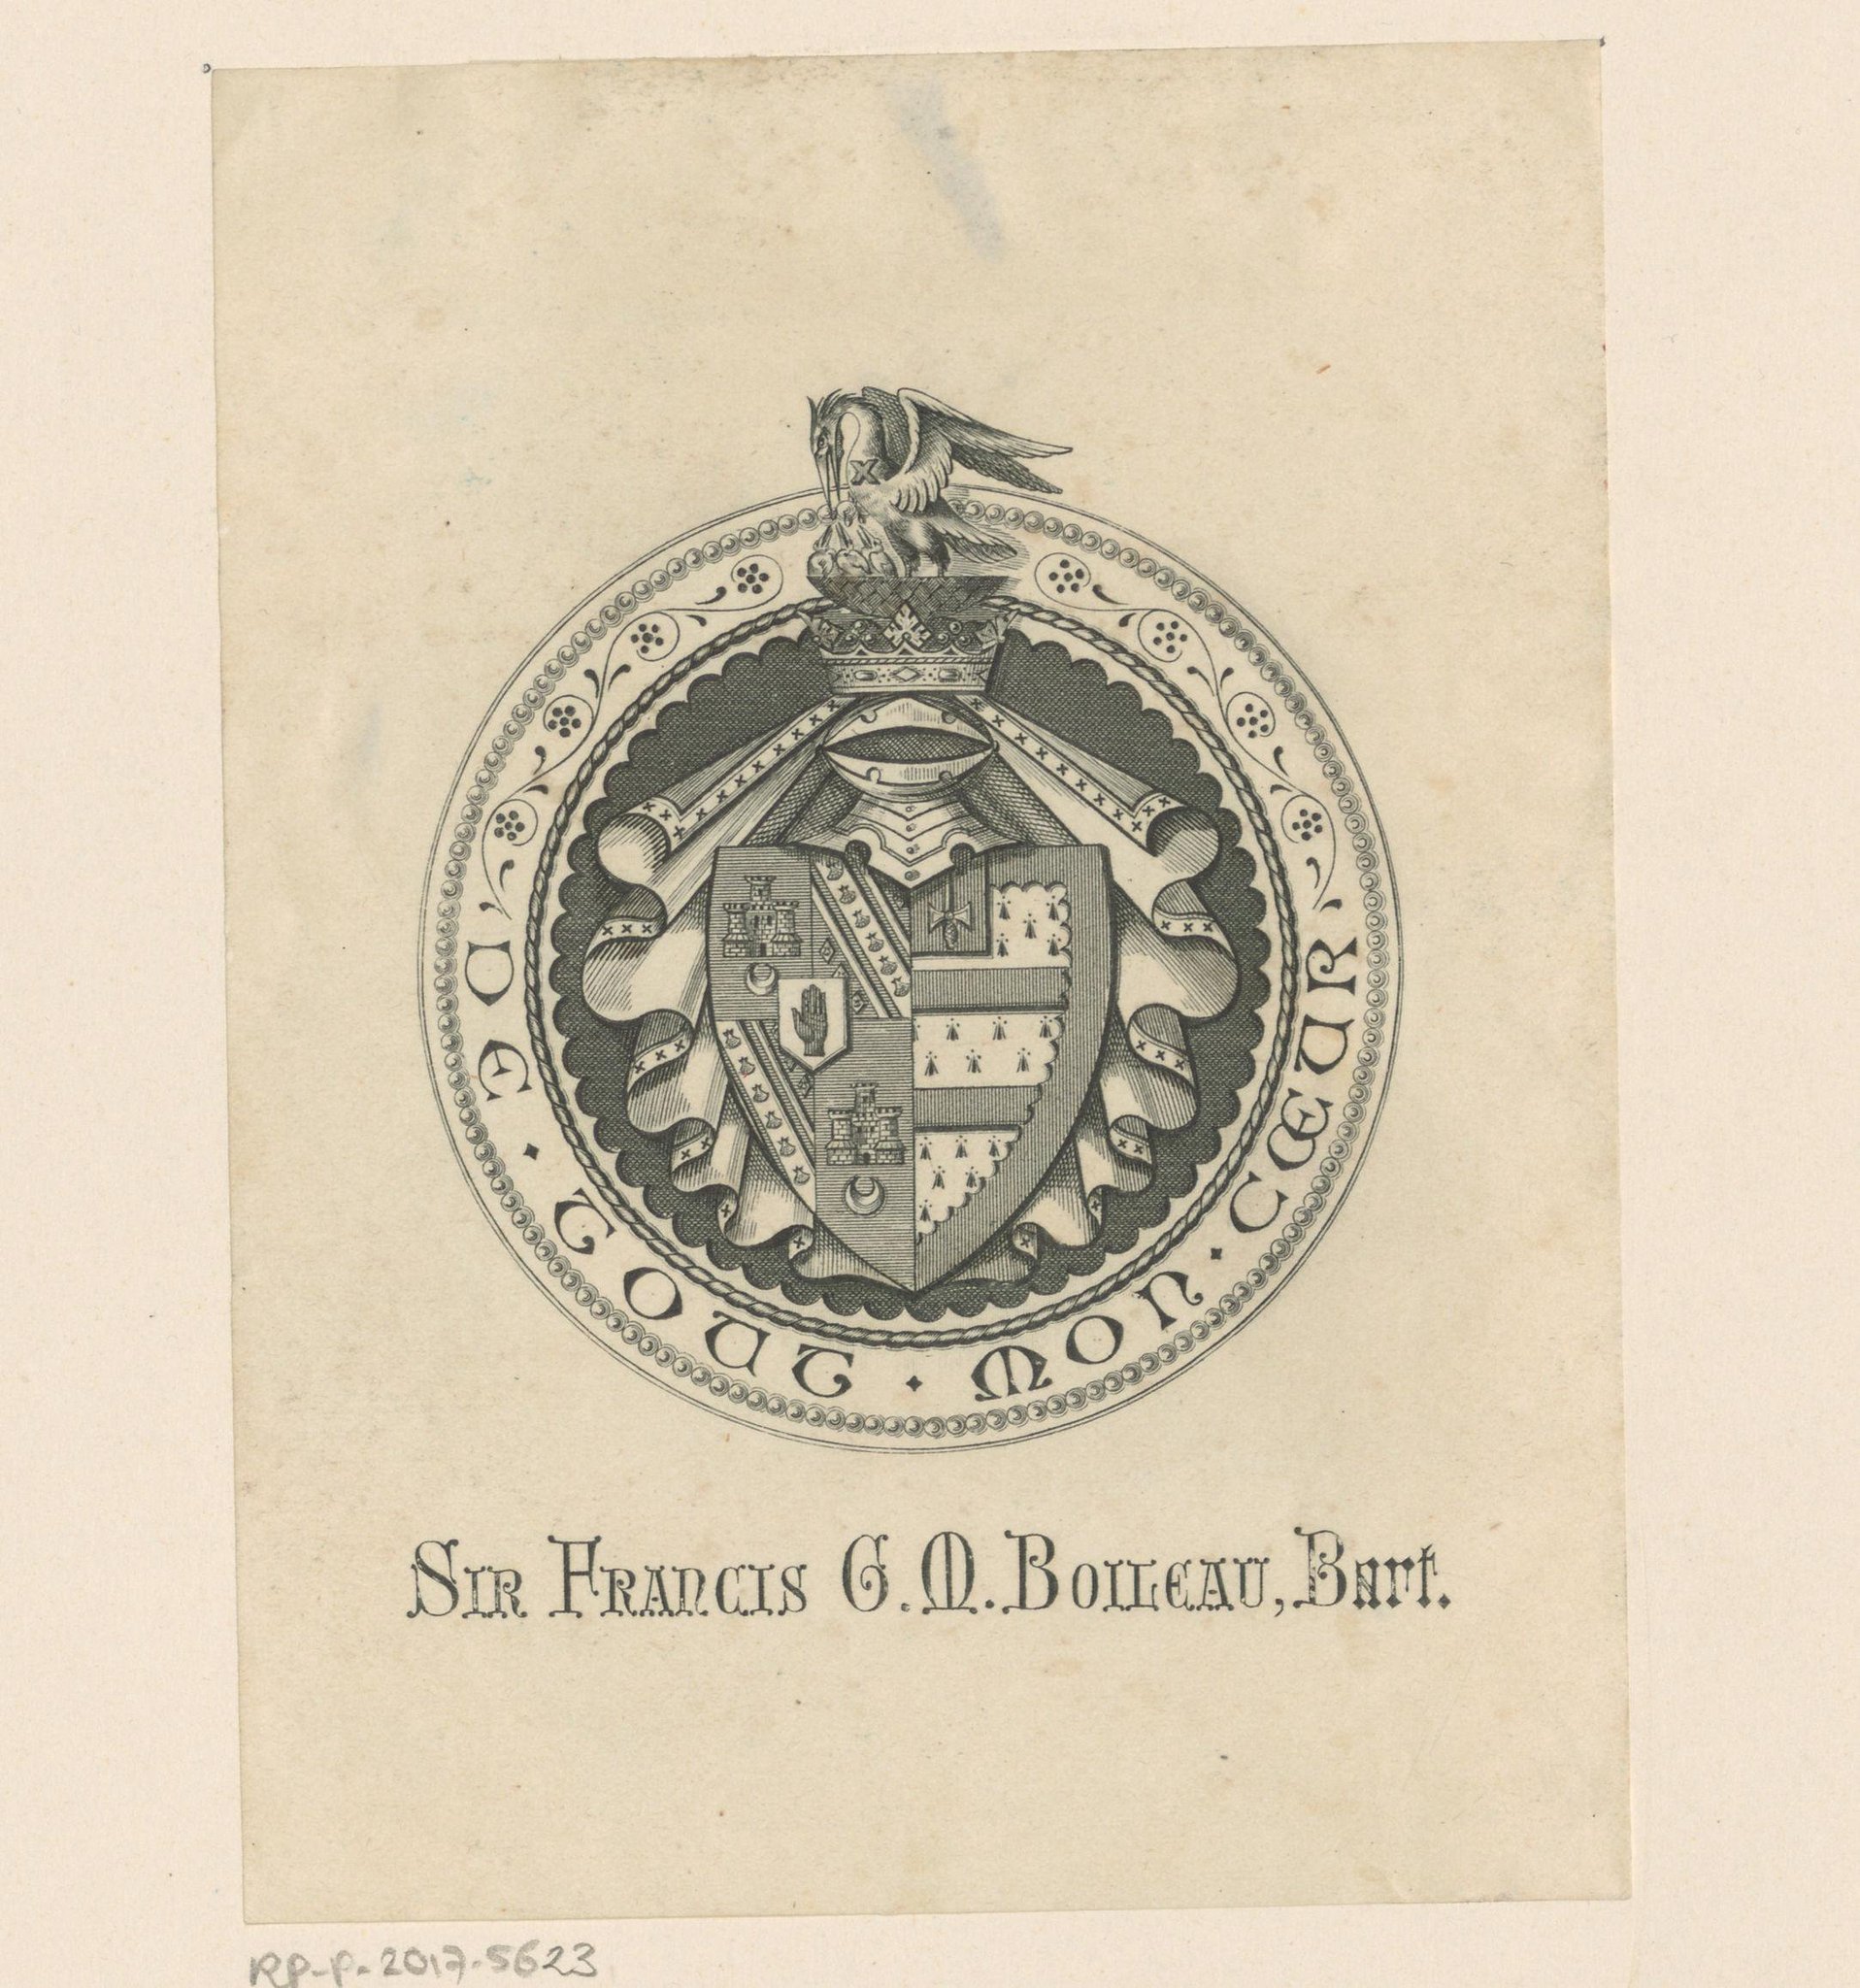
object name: bookplate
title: Ex libris van Sir Francis G.M. Boileau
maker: Anonymous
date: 1840-1900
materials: paper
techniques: etching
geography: england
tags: symbols of christ ~ animals, armorial bearing, heraldry